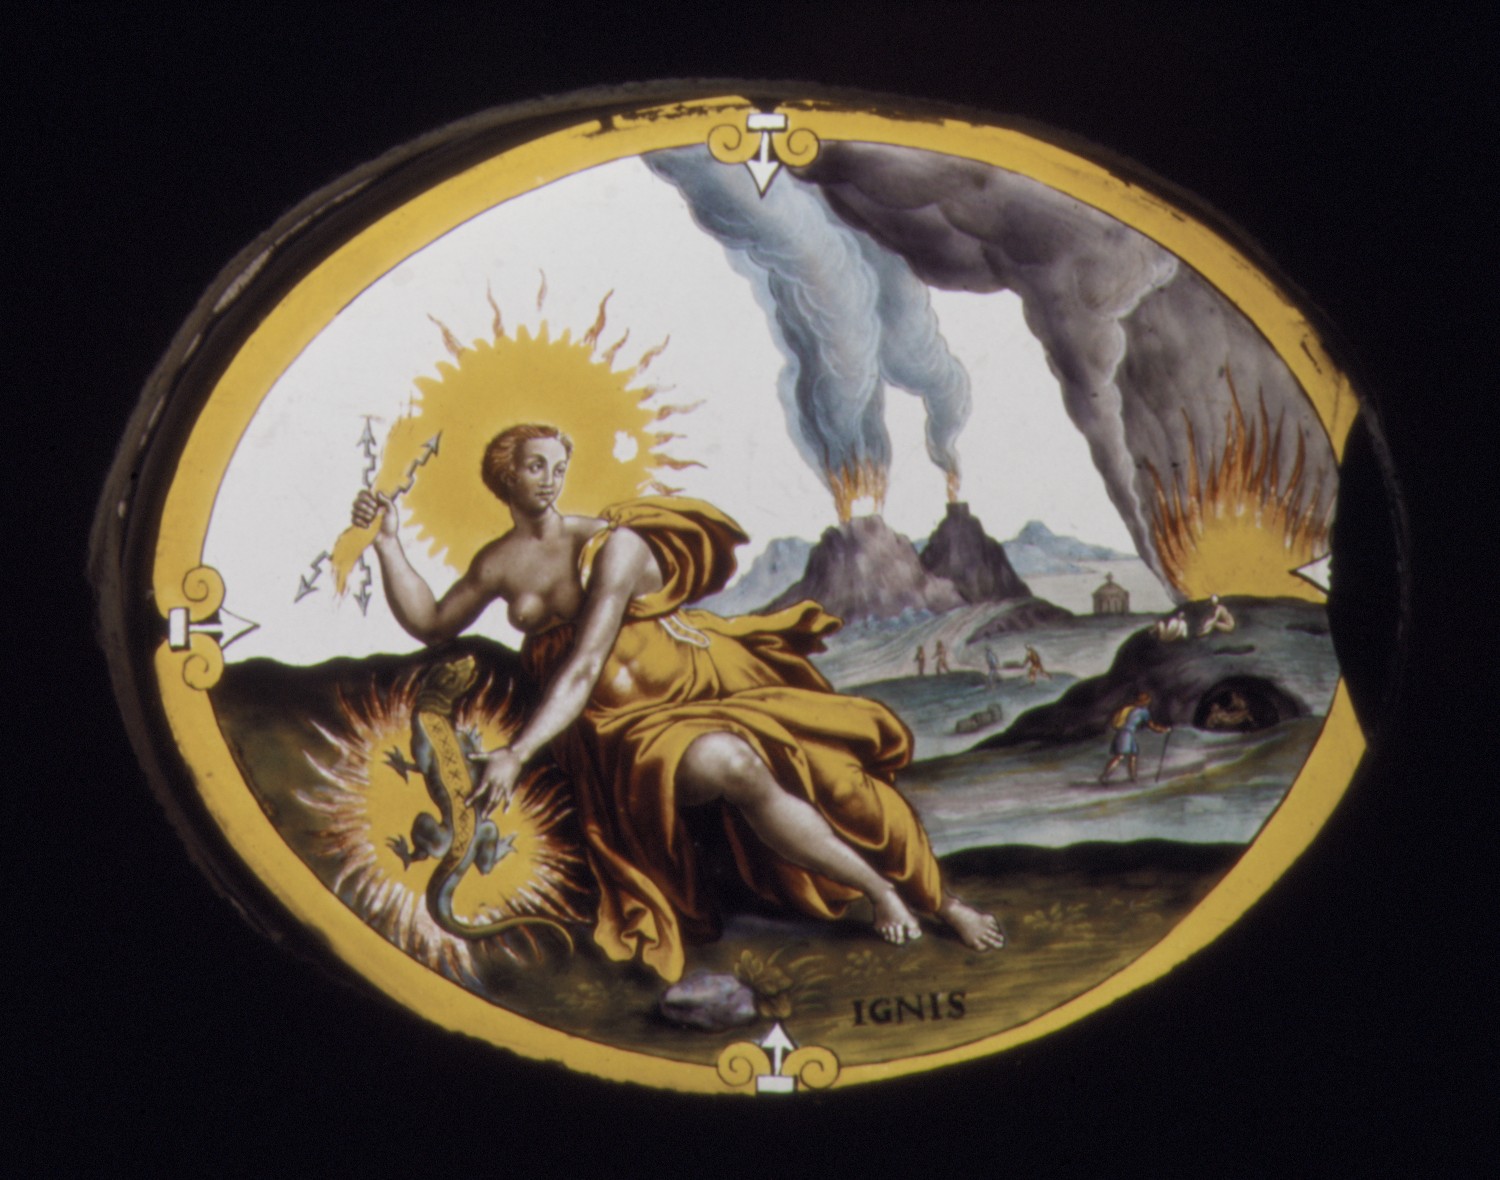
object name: panel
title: The Elements: Fire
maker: christoph murer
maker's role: maker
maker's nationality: swiss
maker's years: 1558-1614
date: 1601-1633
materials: glass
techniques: painting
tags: animals,women,fire,volcanoes